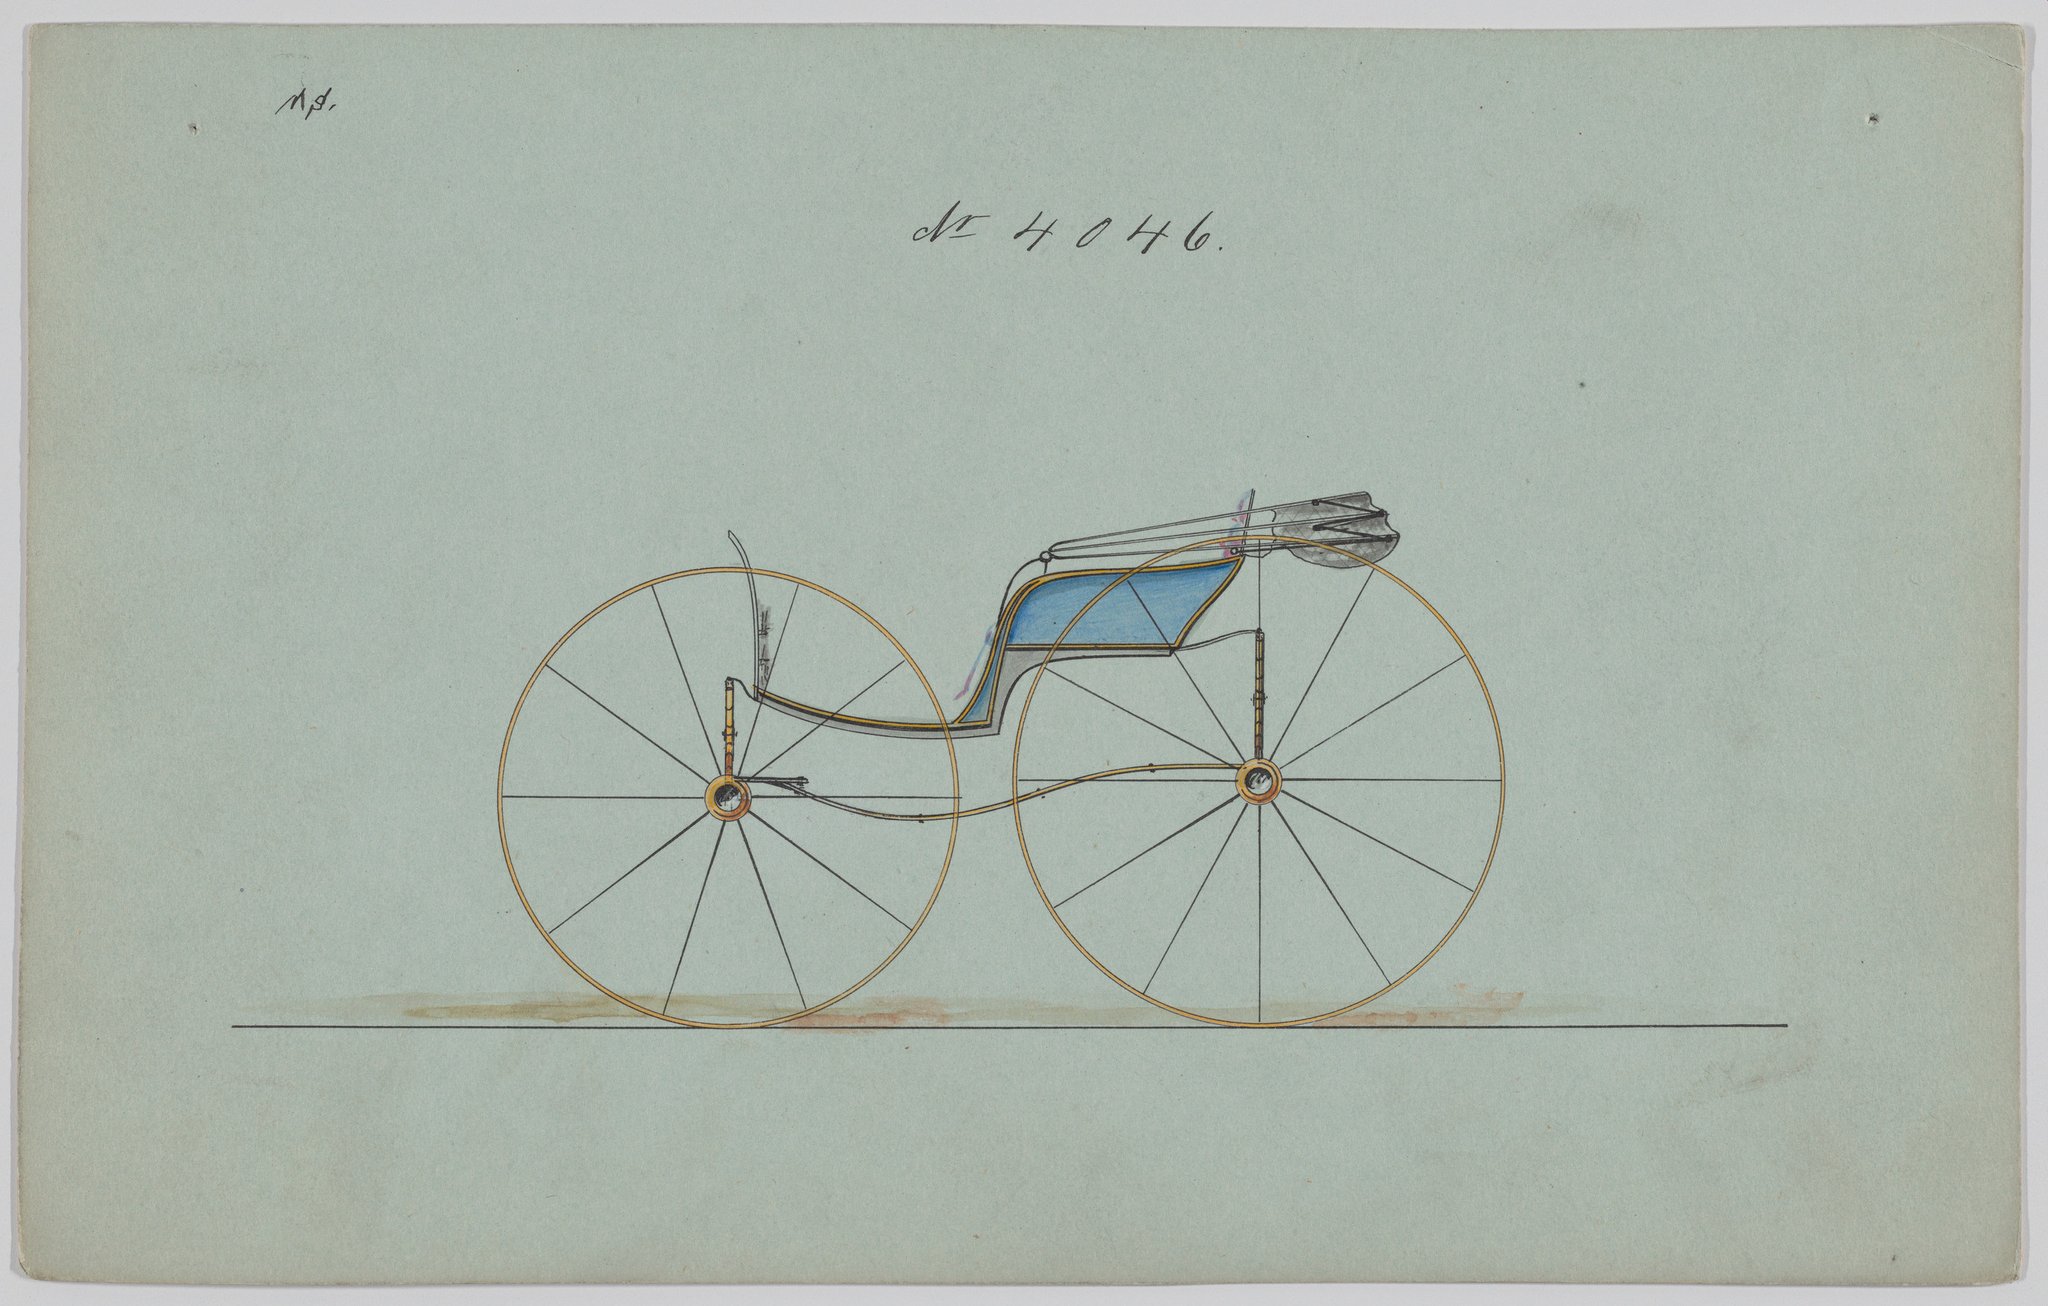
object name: drawing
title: Design for Pony Phaeton, no. 4046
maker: brewster & co.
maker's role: manufacturer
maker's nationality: american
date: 1889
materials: gouache, ink, watercolor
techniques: pen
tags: carriages